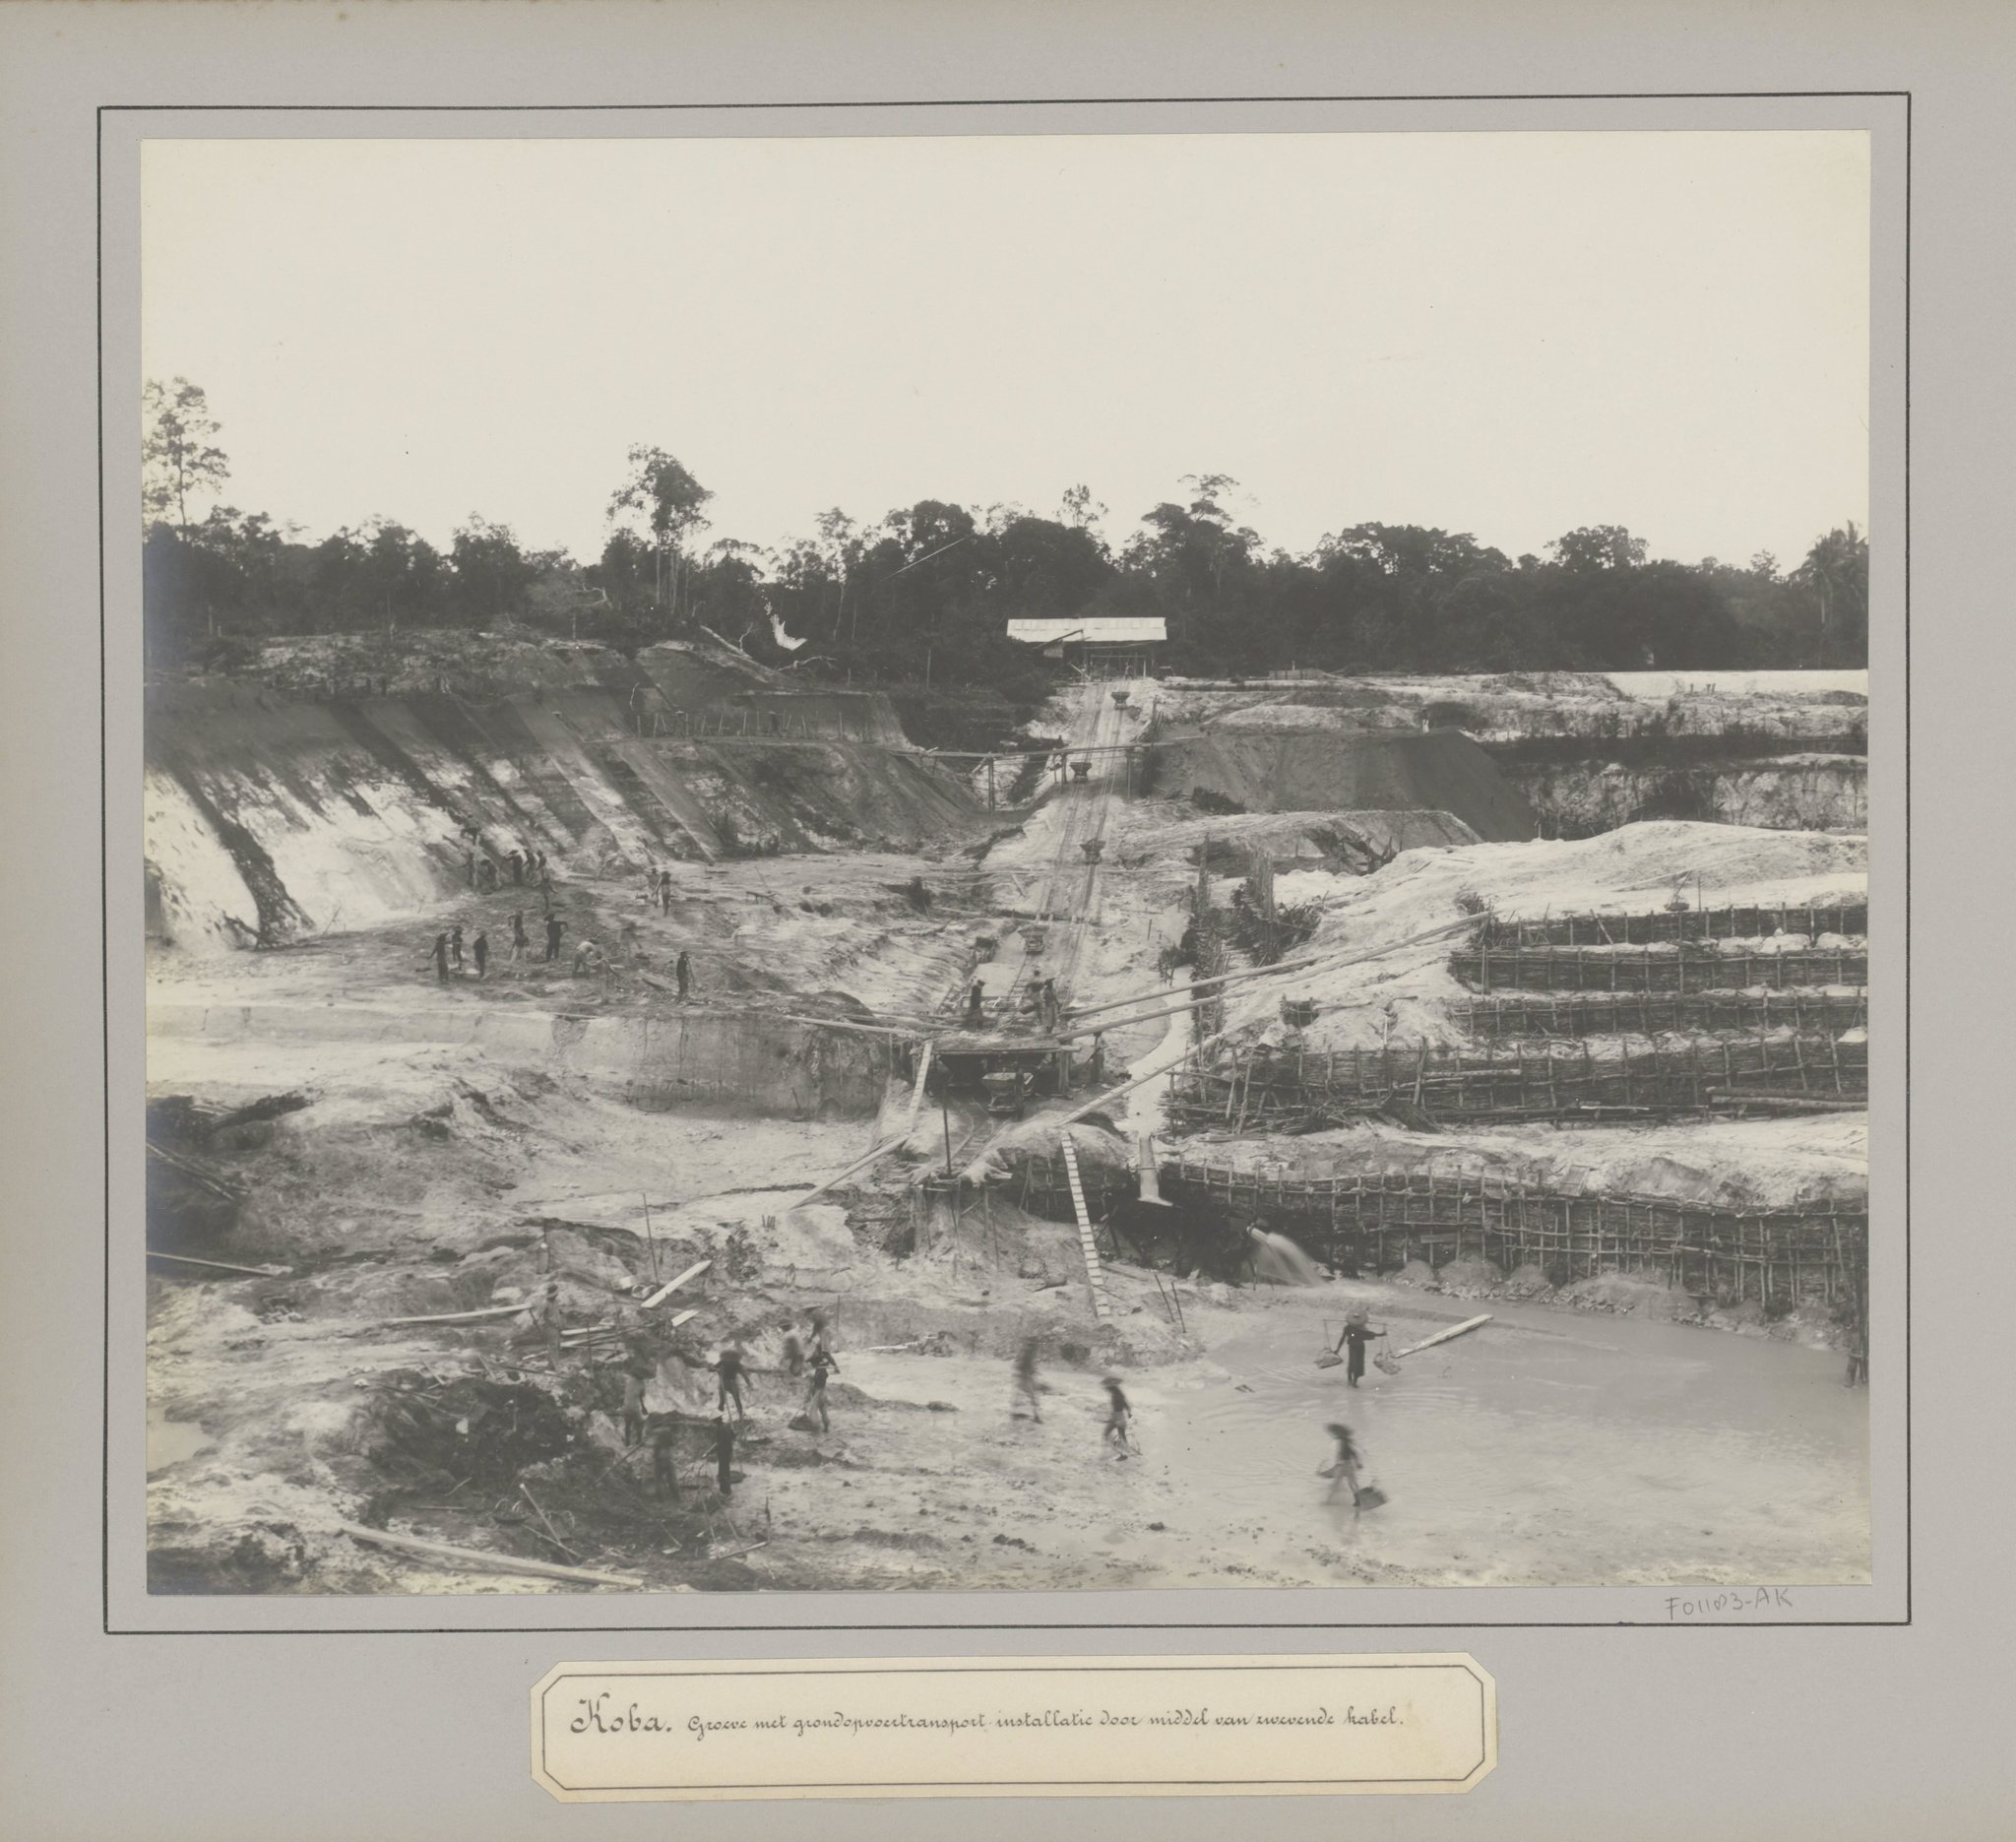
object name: photograph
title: Koba. Groeve met grondopvoertransport-installatie door middel van zwevende kabel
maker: Anonymous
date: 1900-1920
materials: photographic support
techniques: gelatin silver print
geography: koba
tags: mining, funicular railway, minerals and metals: tin, working class, labourers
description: Onderdeel van Fotoalbum over de tinwinning op Bangka.